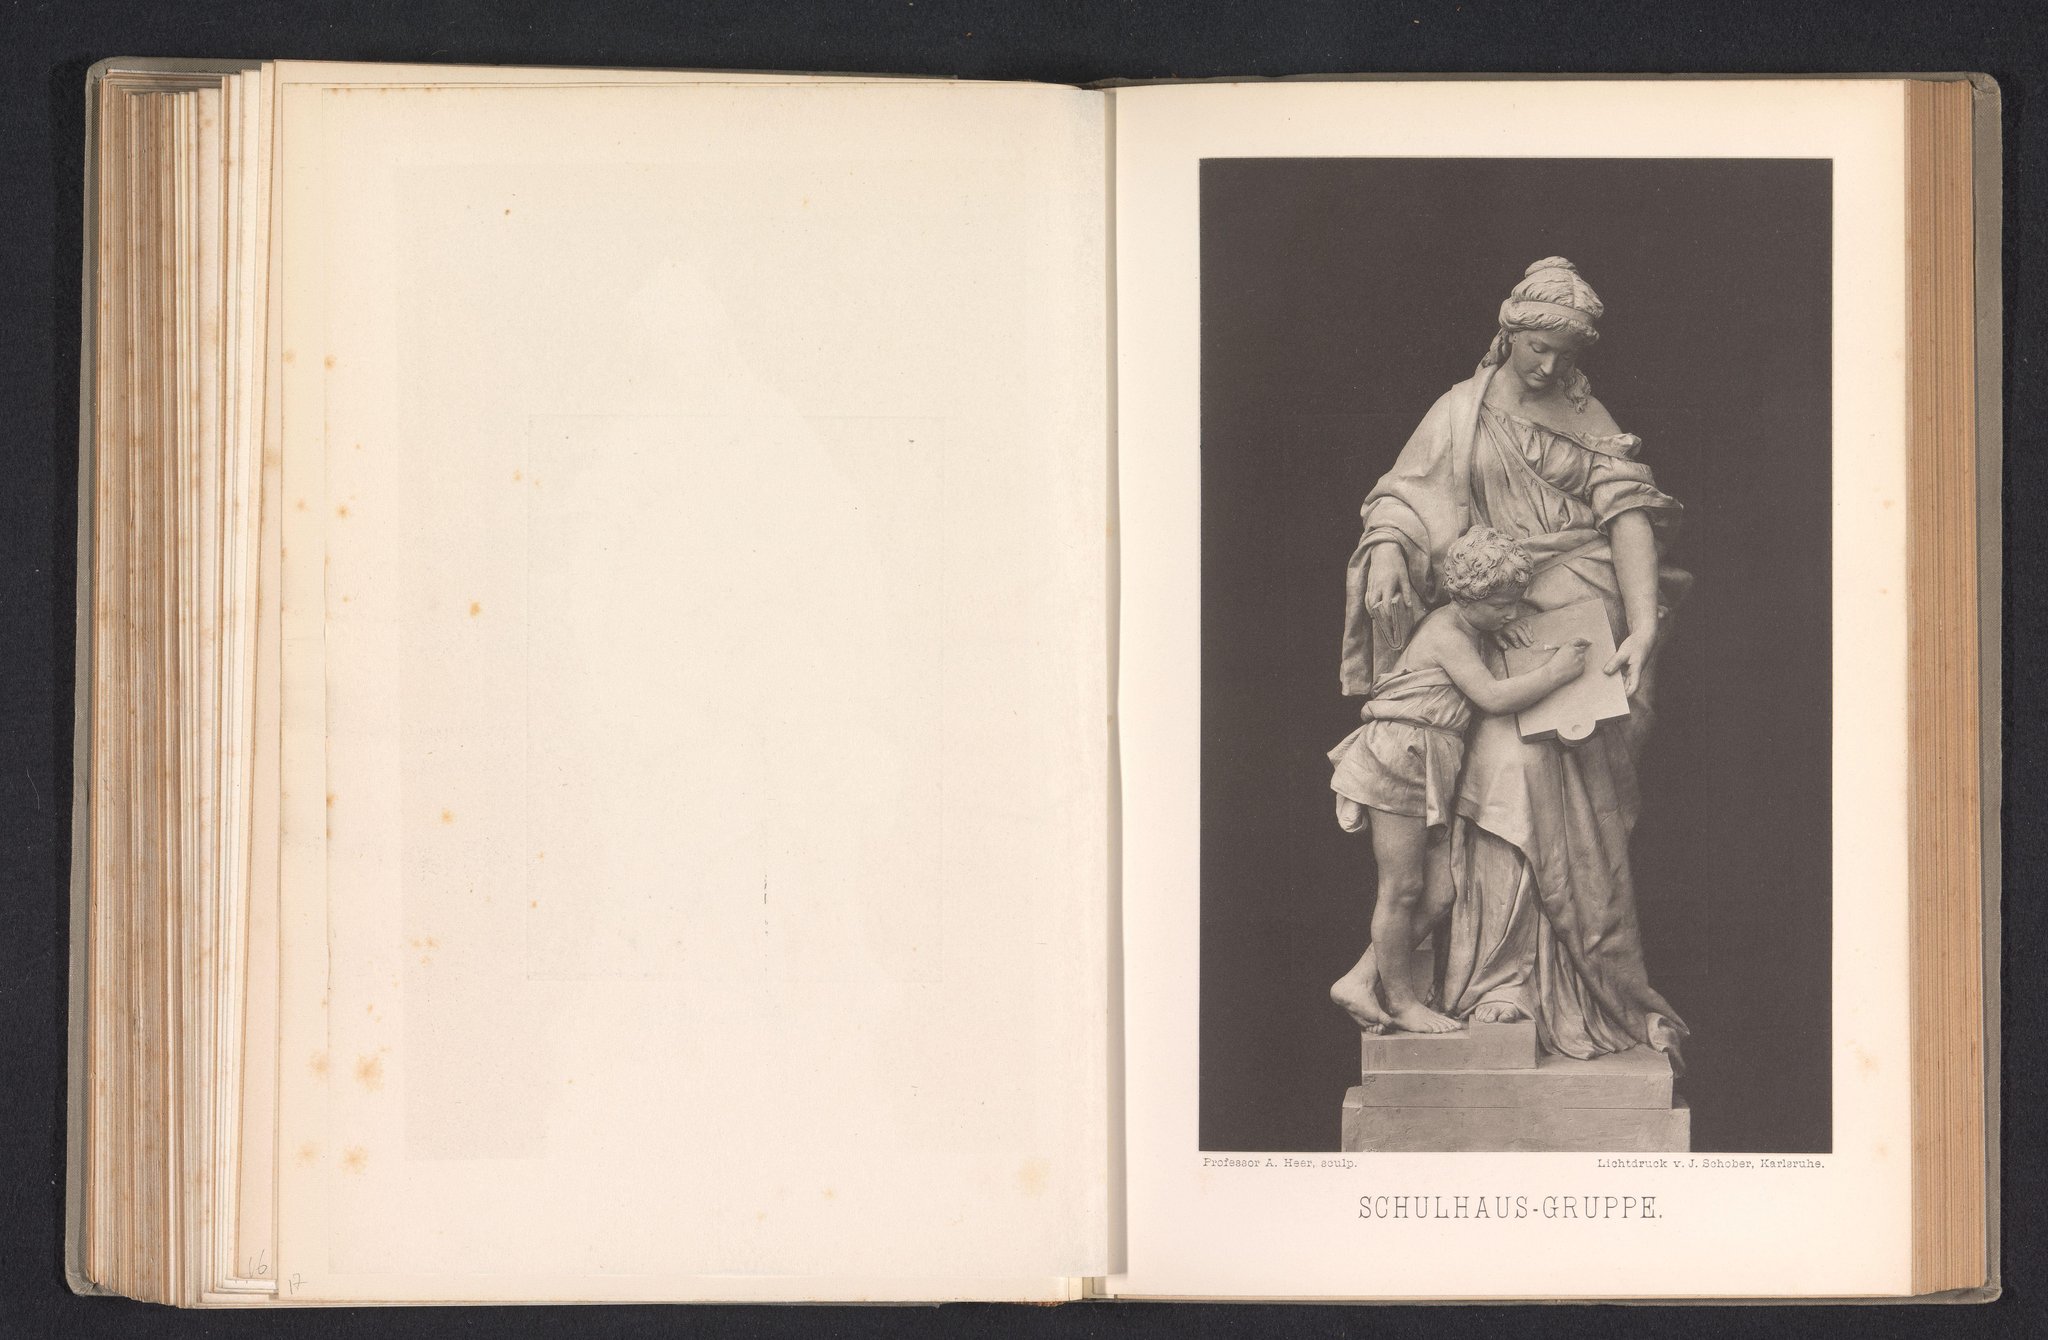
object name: photomechanical print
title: Schulhaus-gruppe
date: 1878-1883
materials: paper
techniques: photograph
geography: dresden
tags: writing tablets, adult woman, child, sculpture